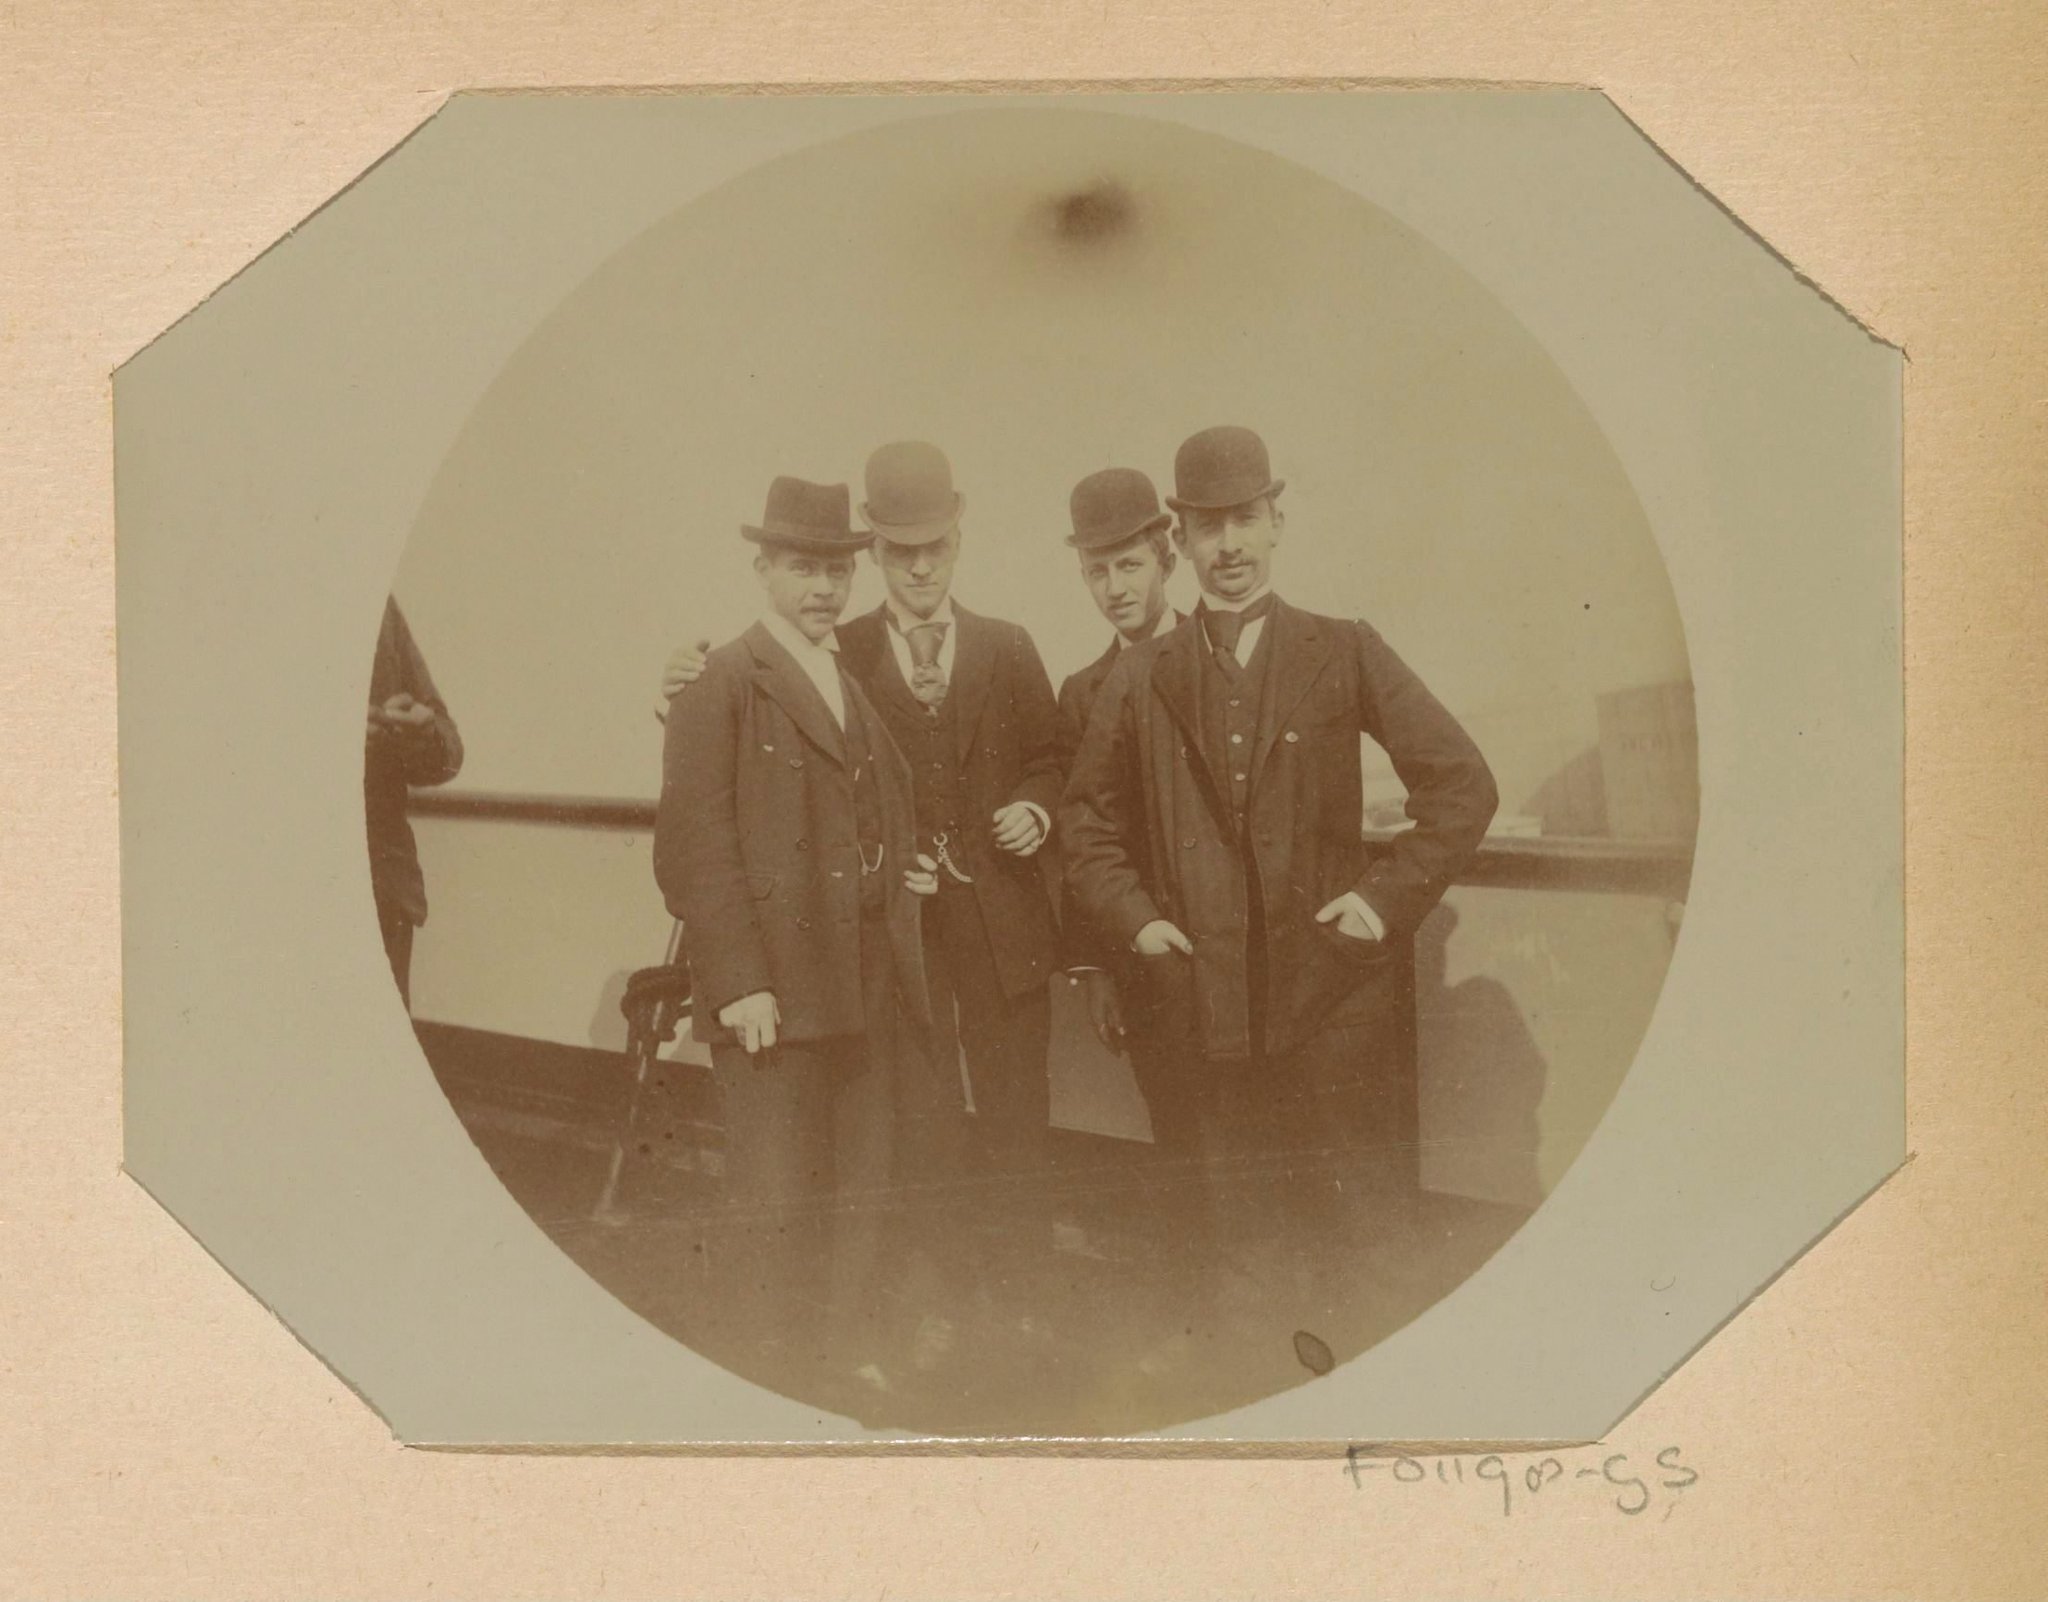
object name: album leaf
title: Vier studenten van de Openbare Handelsschool poseren aan boord van een schip tijdens een excursie naar de Oostzee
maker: willem frederik piek jr.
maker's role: fotograaf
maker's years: 1874-1954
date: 1889-1893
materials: paper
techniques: gelatin silver print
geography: baltic sea region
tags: ships (in general), student